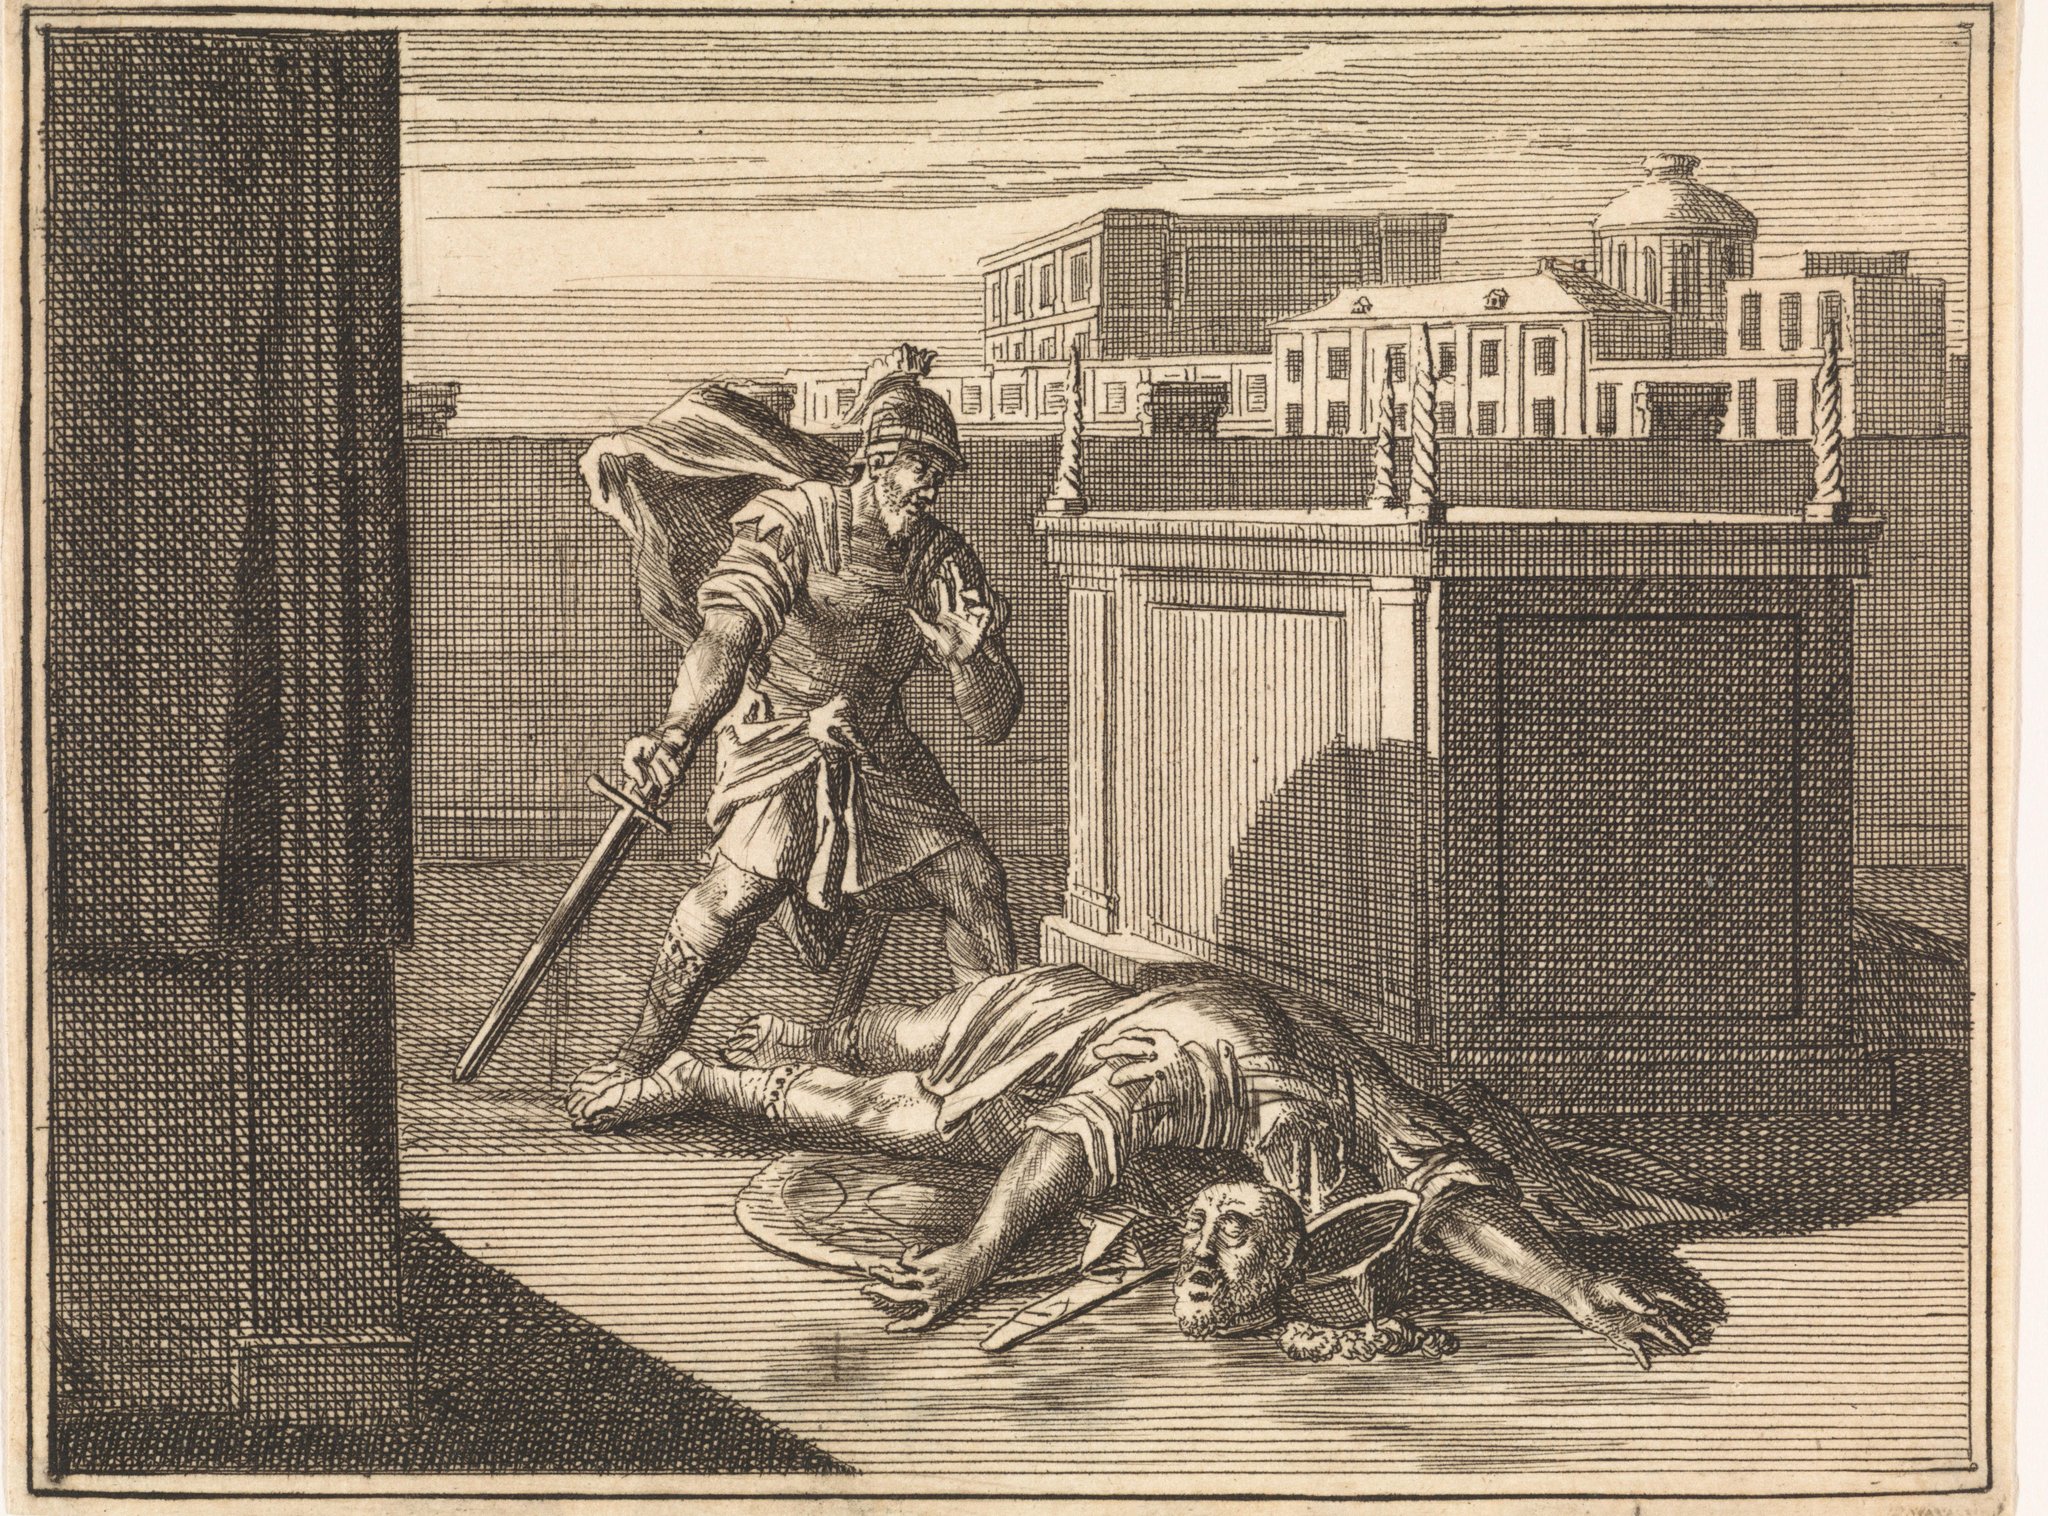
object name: print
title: Joab door Benaja gedood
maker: caspar luyken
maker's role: draughtsman, print maker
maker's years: 1672-1708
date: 1712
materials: paper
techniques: etching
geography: amsterdam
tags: joab killed by benaiah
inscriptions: collector's mark: Lugt 2228, number: ‘122’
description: Illustratie uit: Luyken, Jan. De schriftuurlyke geschiedenissen en gelykenissen van het Oude en Nieuwe Verbond, 2 delen. Amsterdam: Wed. Pieter Arentsz II en Cornelis van der Sys, 1712, dl. I.